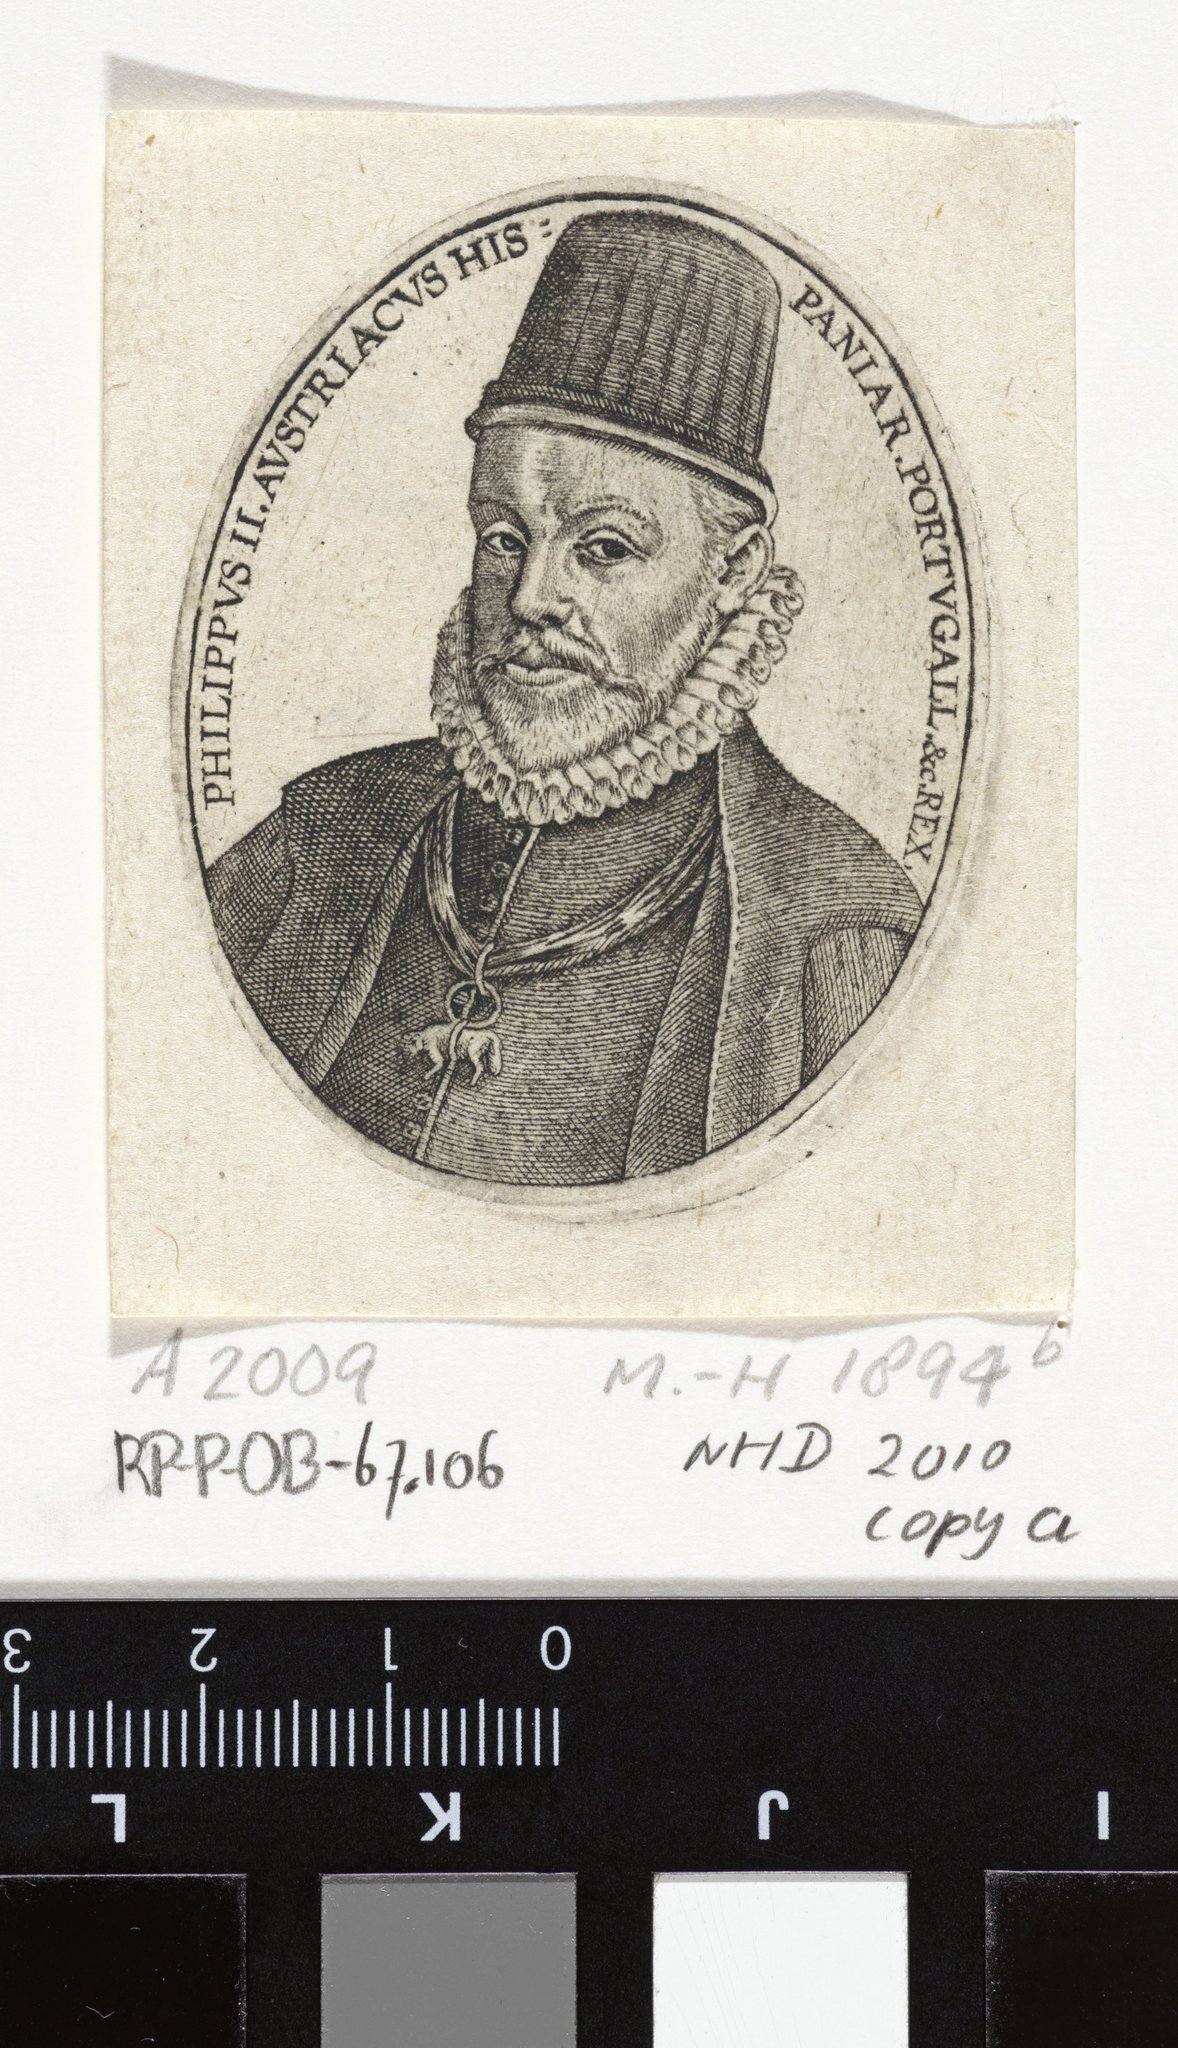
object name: print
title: Portret van Filips II, koning van Spanje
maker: Anonymous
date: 1599-1649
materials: paper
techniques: engraving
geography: antwerp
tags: philip ii of spain, knighthood order of the golden fleece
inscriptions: collector's mark: Lugt 2228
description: Hij draagt een lint met de Orde van het Gulden Vlies.